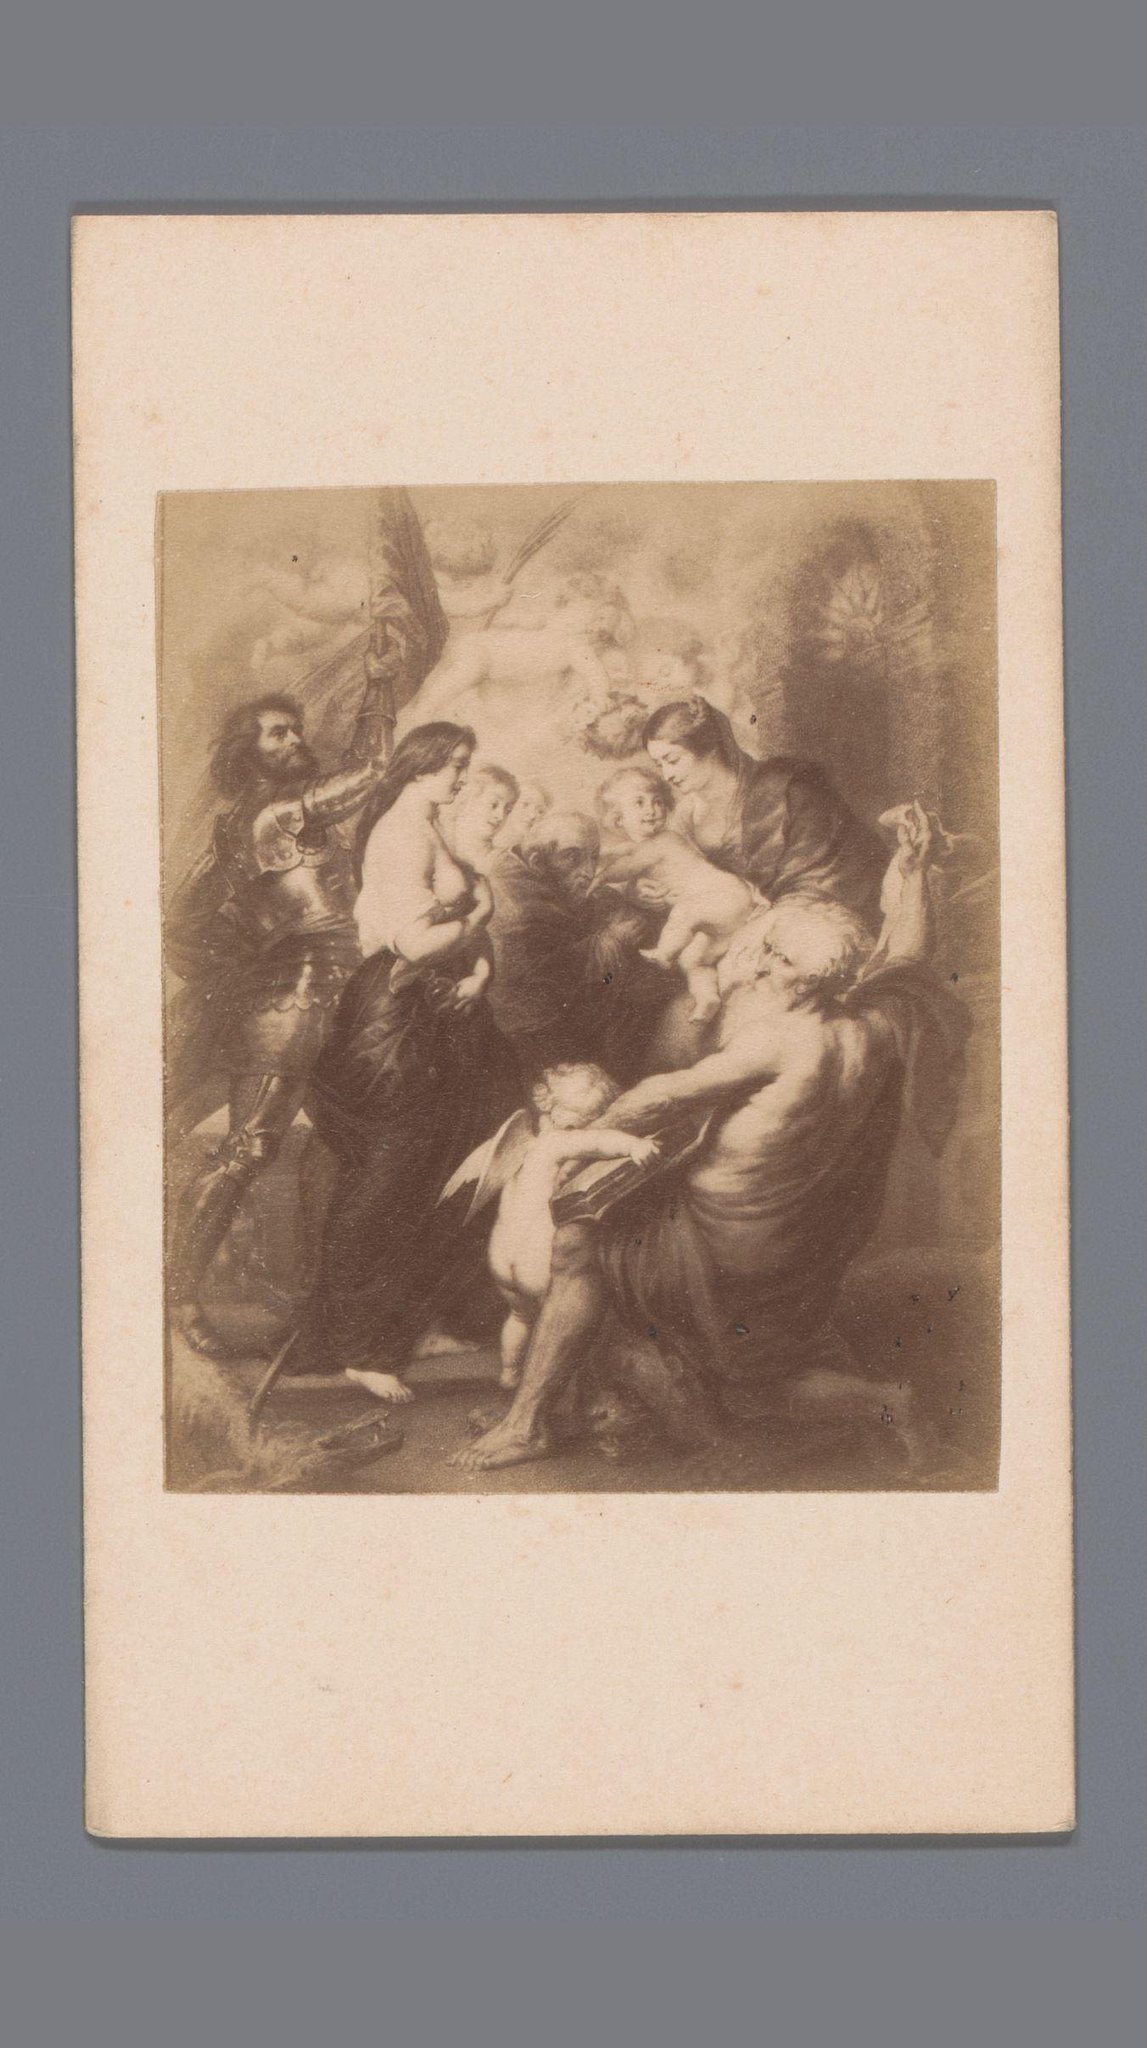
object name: photograph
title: Rubens. Famille de Rubens. Eglise St.Jacques Anvers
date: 1858-1866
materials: cardboard, paper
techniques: albumen print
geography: antwerp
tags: madonna: mary sitting or enthroned, the christ-child in her lap (or in front of her bosom) (mary sometimes represented half-length), madonna accompanied by saint(s)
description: Het schilderij van Rubens hangt bij zijn graf in de Sint-Jacobskerk te Antwerpen.